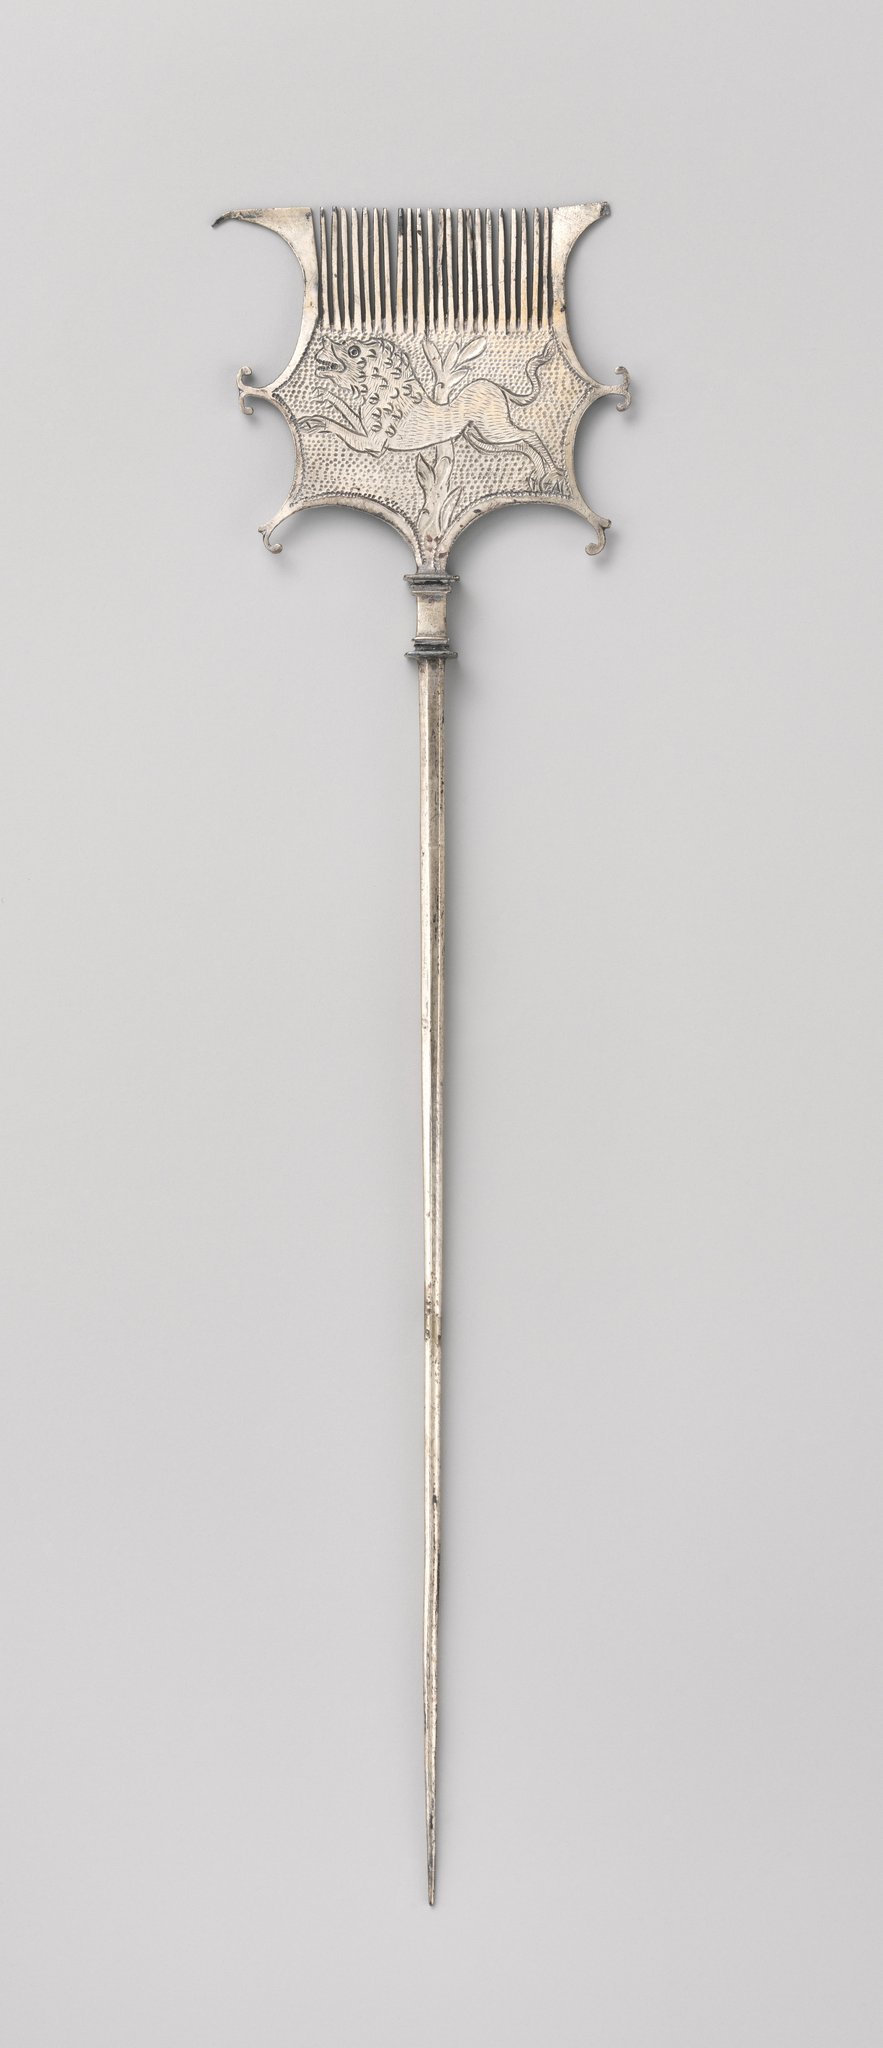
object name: comb and pin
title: Silver comb and pin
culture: roman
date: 67-35 BCE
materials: silver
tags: dogs,lions